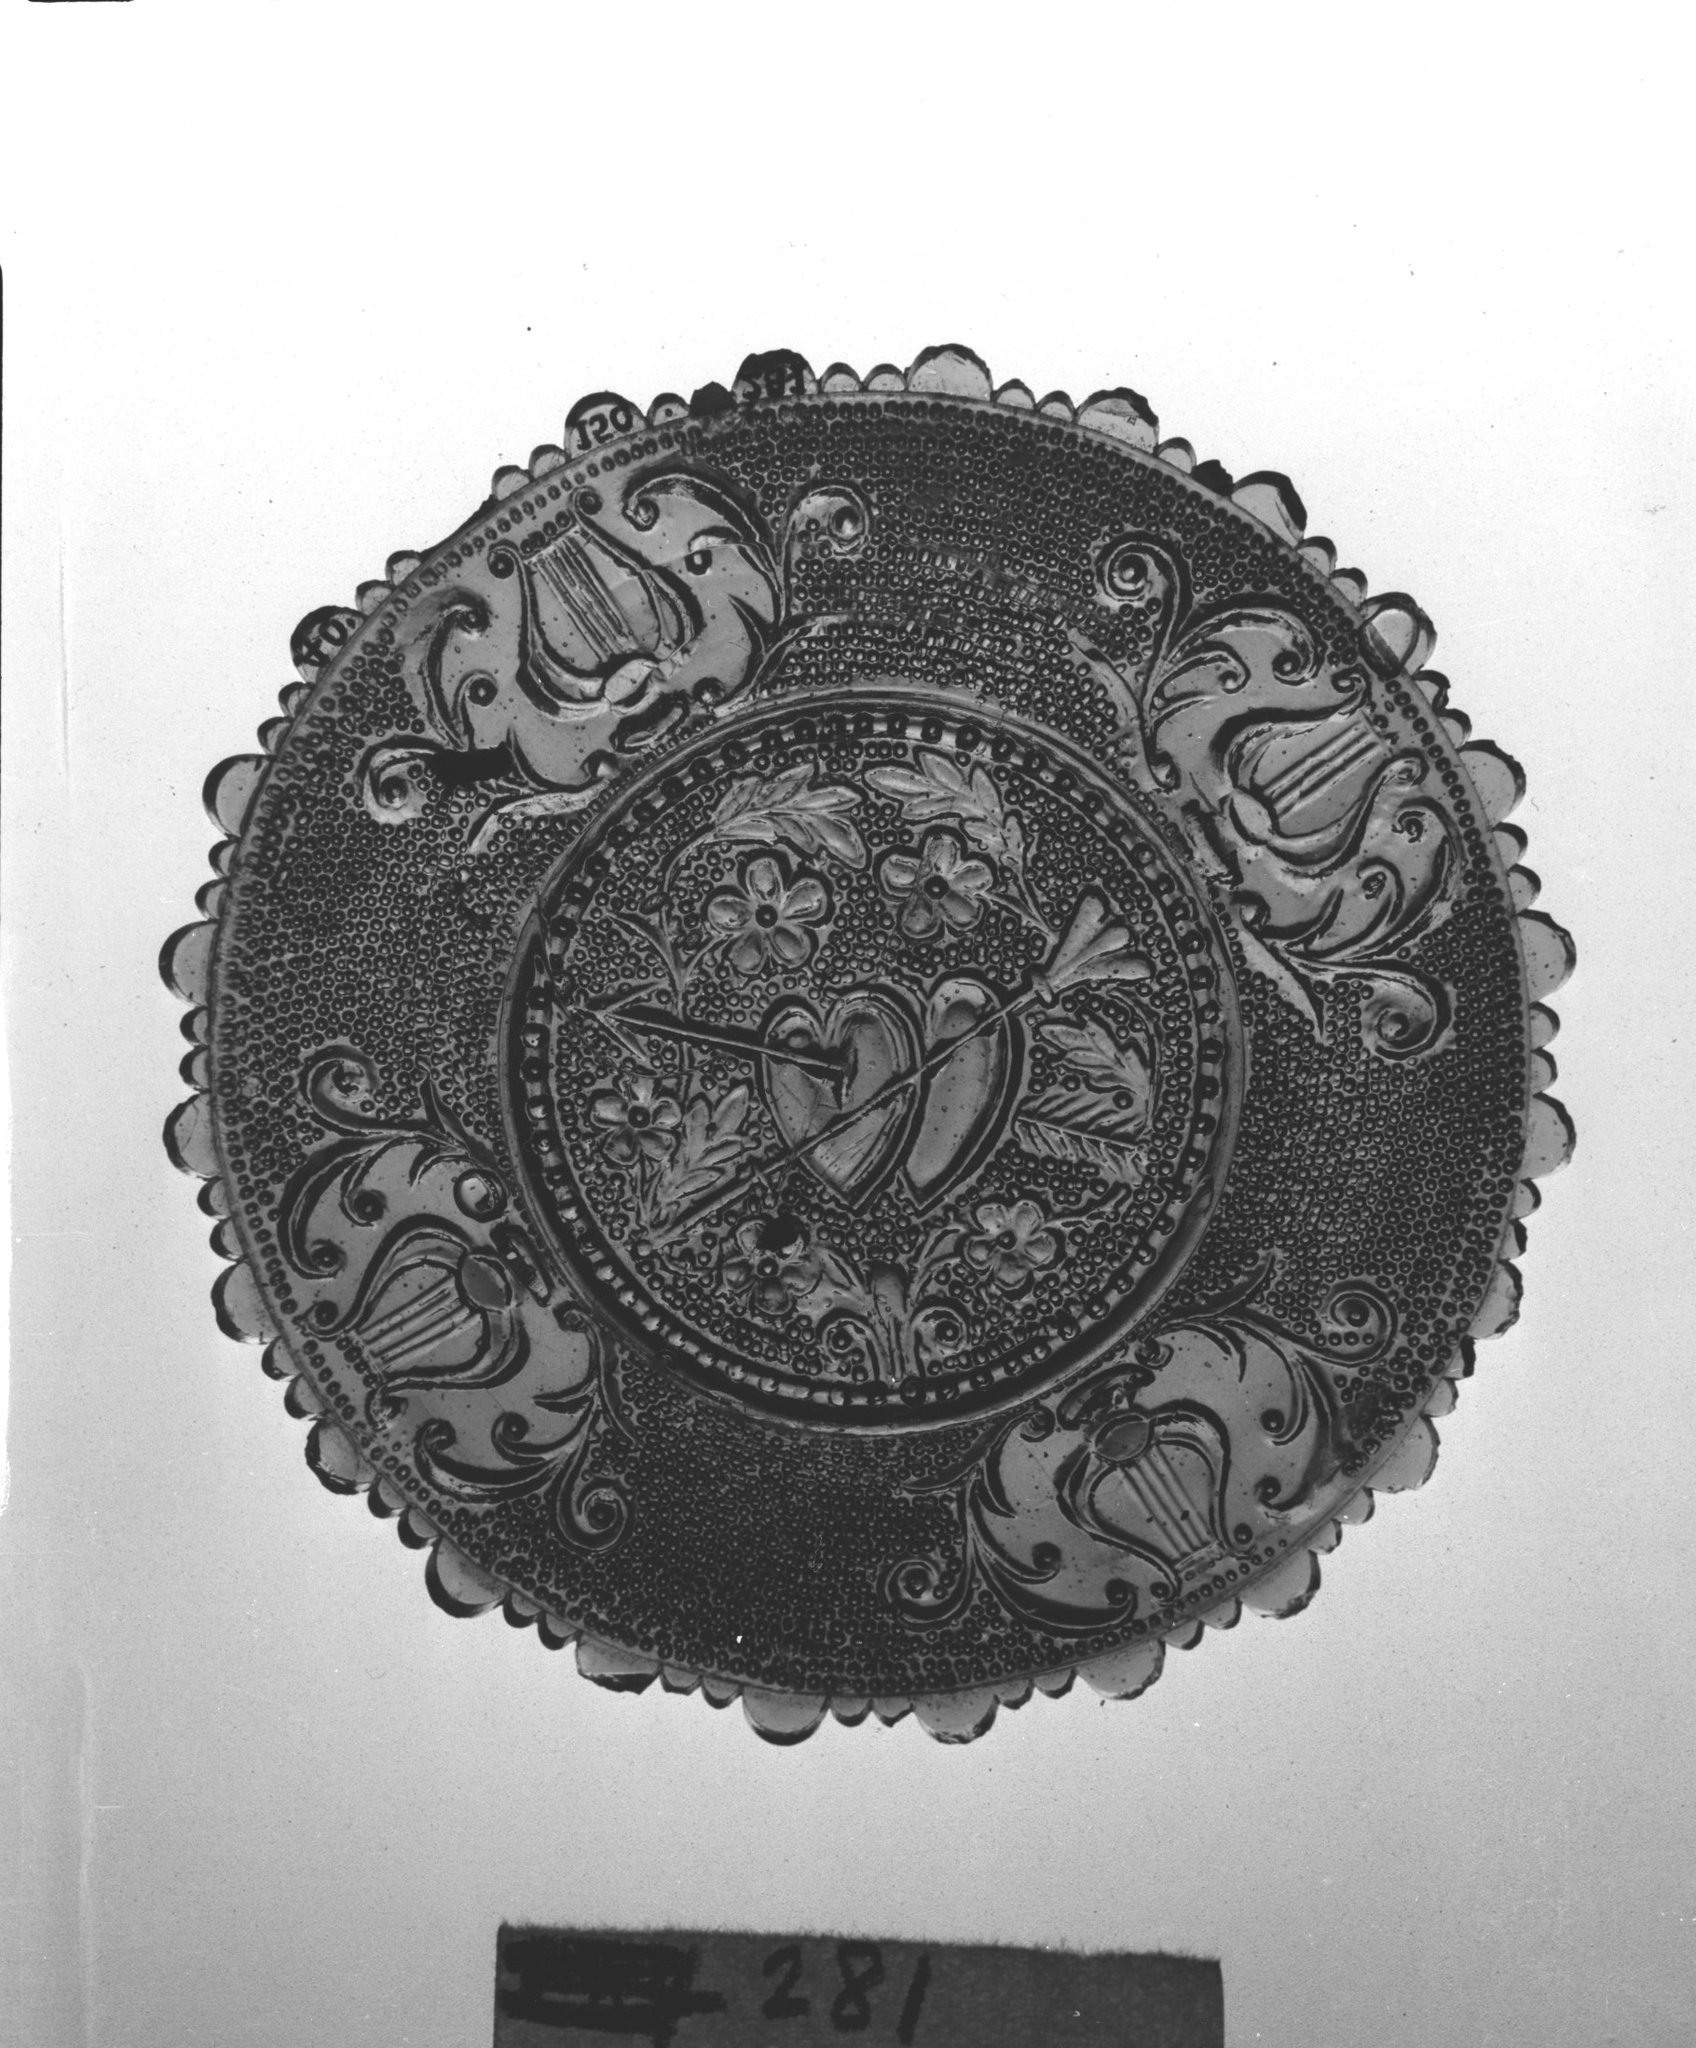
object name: cup plate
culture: american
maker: boston & sandwich glass company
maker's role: maker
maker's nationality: american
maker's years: 1825-1888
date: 1801-1900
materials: glass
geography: united states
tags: arrows,lyres